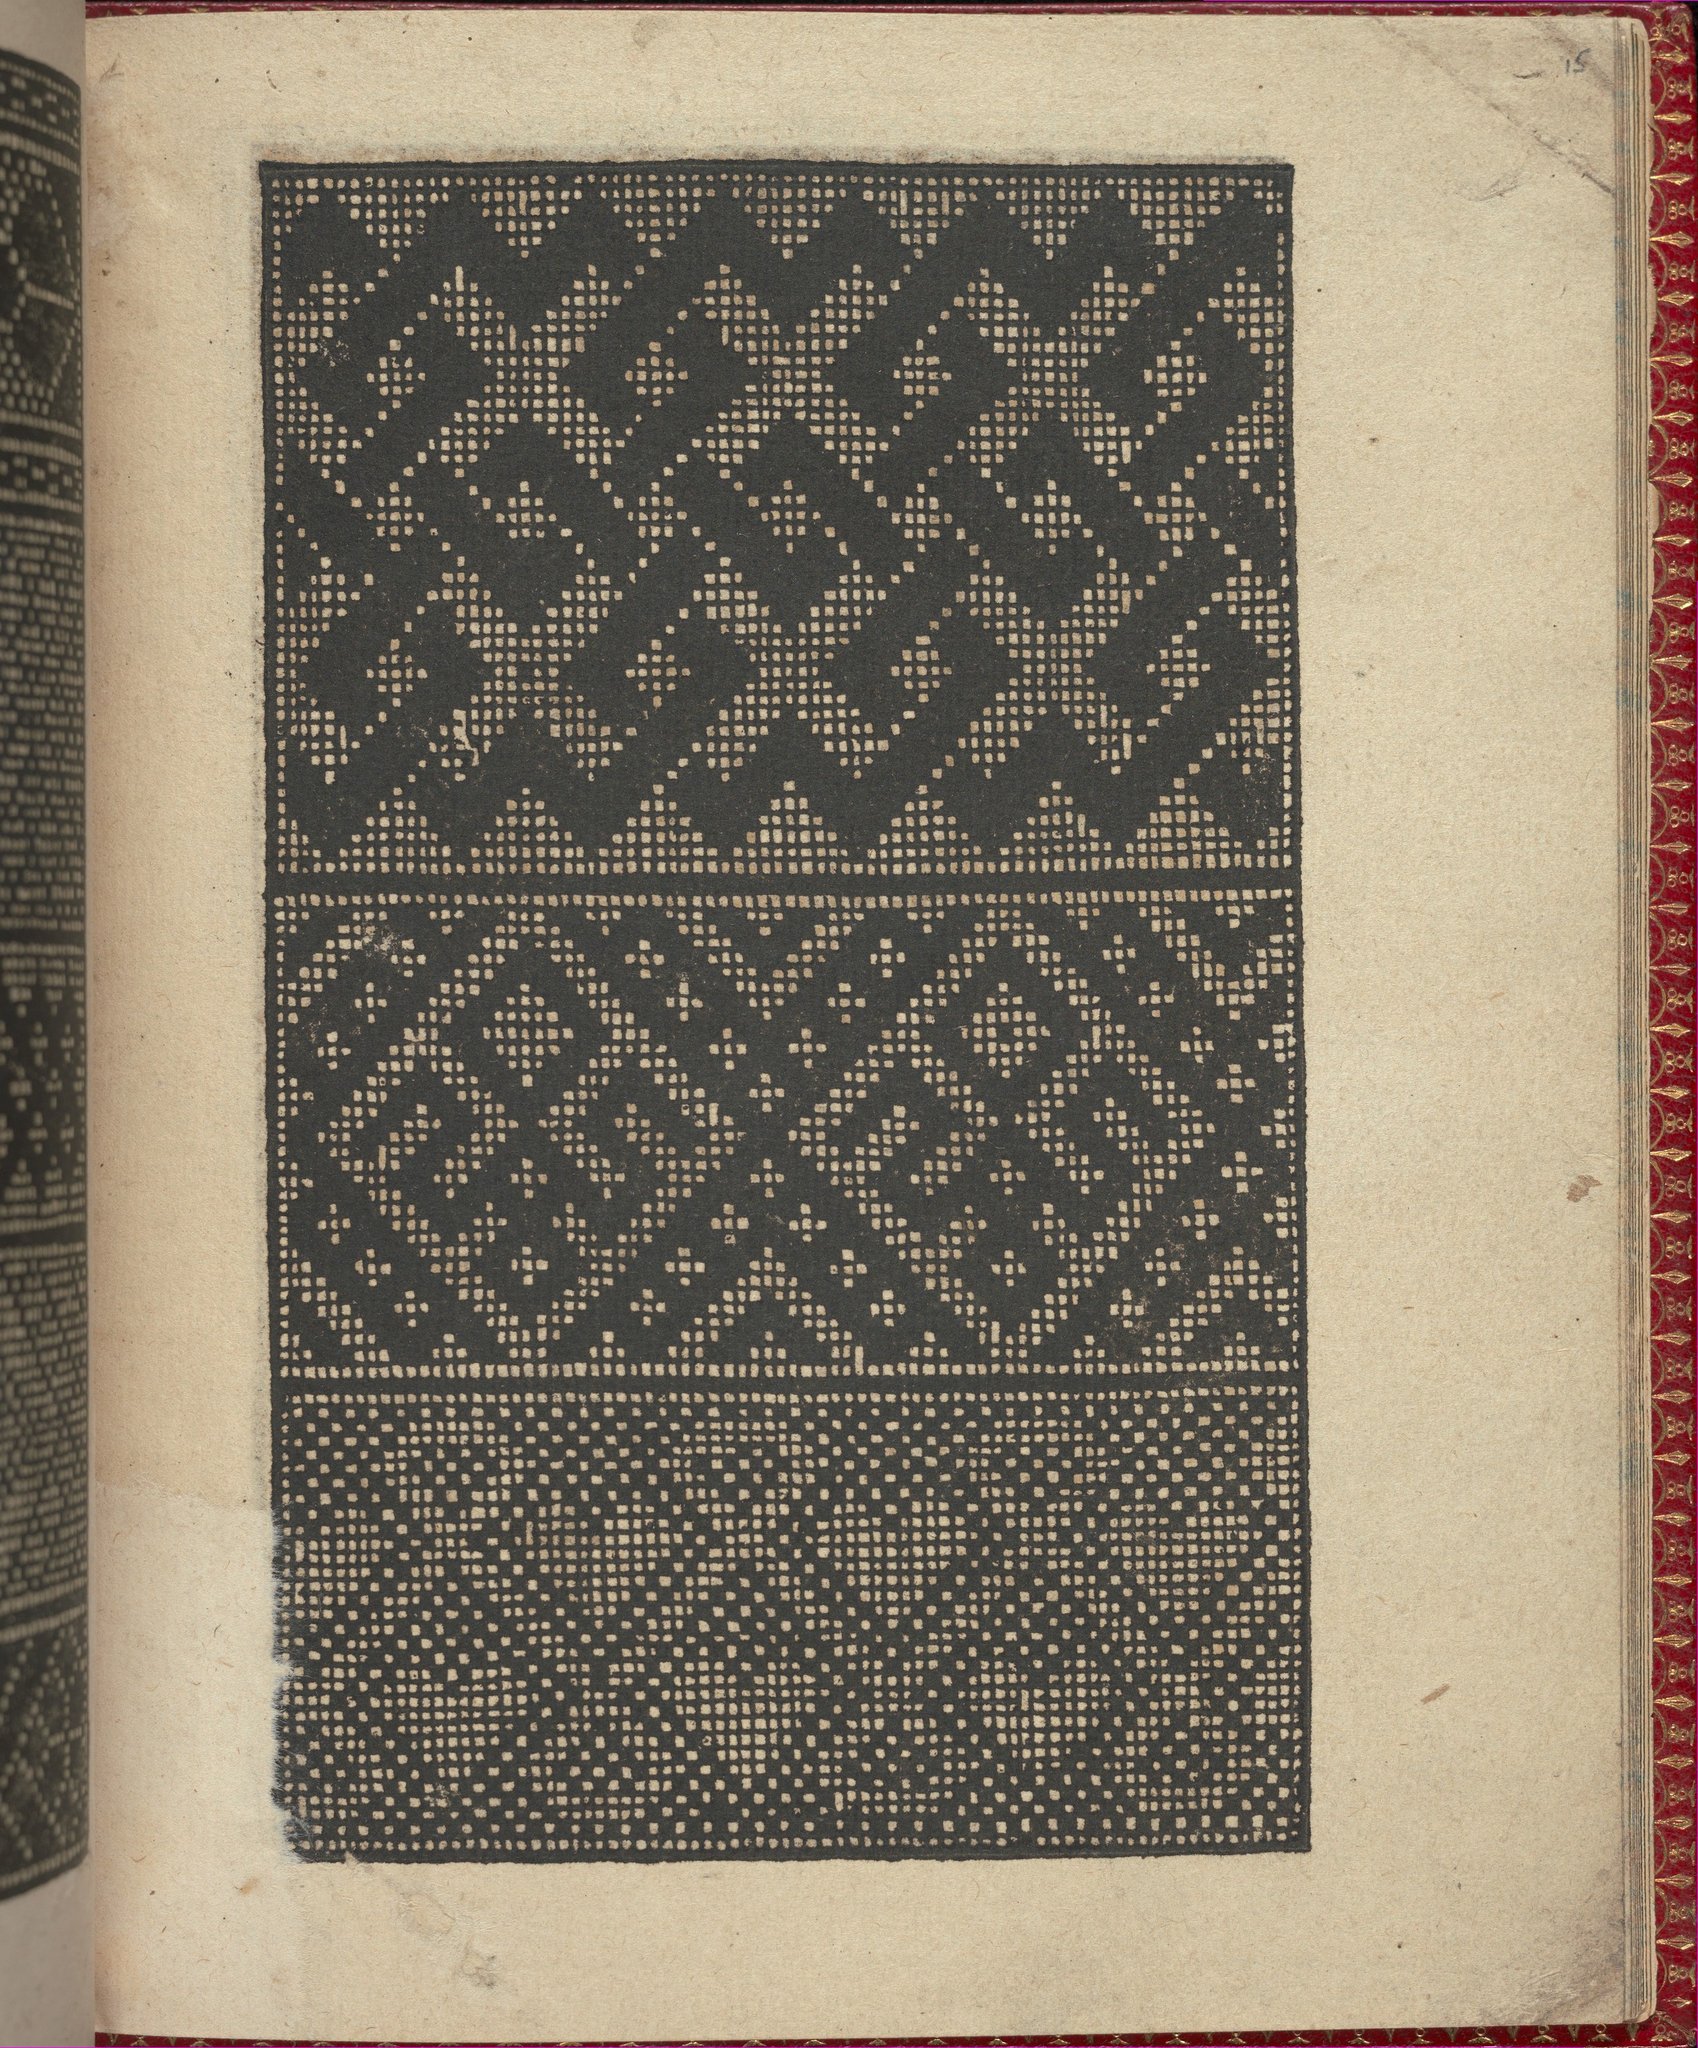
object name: book print ornament architecture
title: Ce est ung tractat de la noble art de leguille ascavoir ouvraiges de spaigne... page 15 (recto)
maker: willem vosterman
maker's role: printer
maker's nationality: netherlandish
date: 1527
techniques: woodcut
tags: ornament